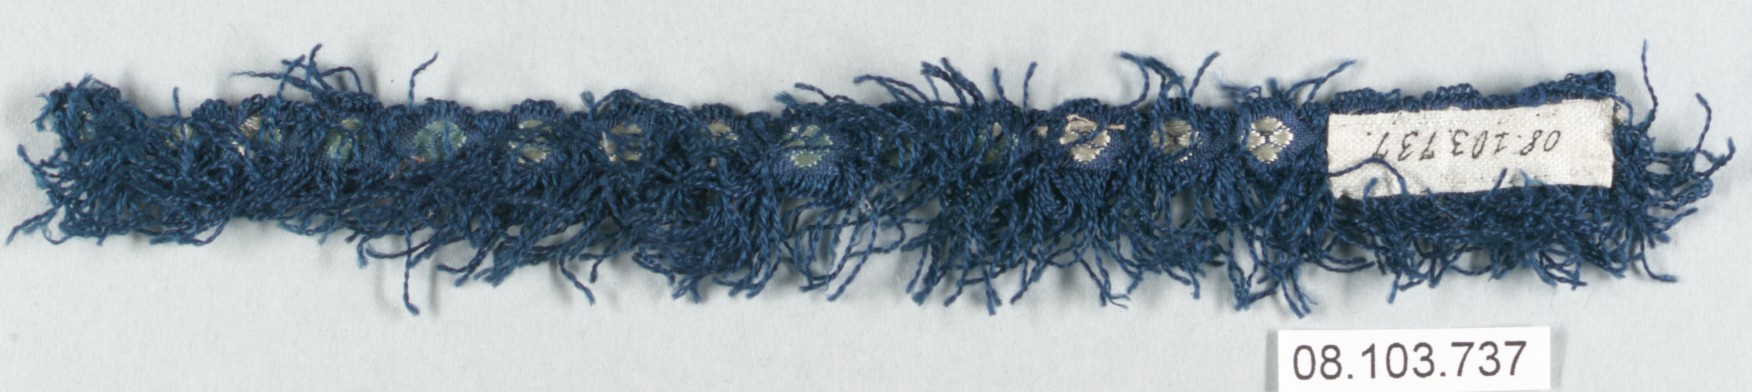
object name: fringe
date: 1701-1900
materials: silk